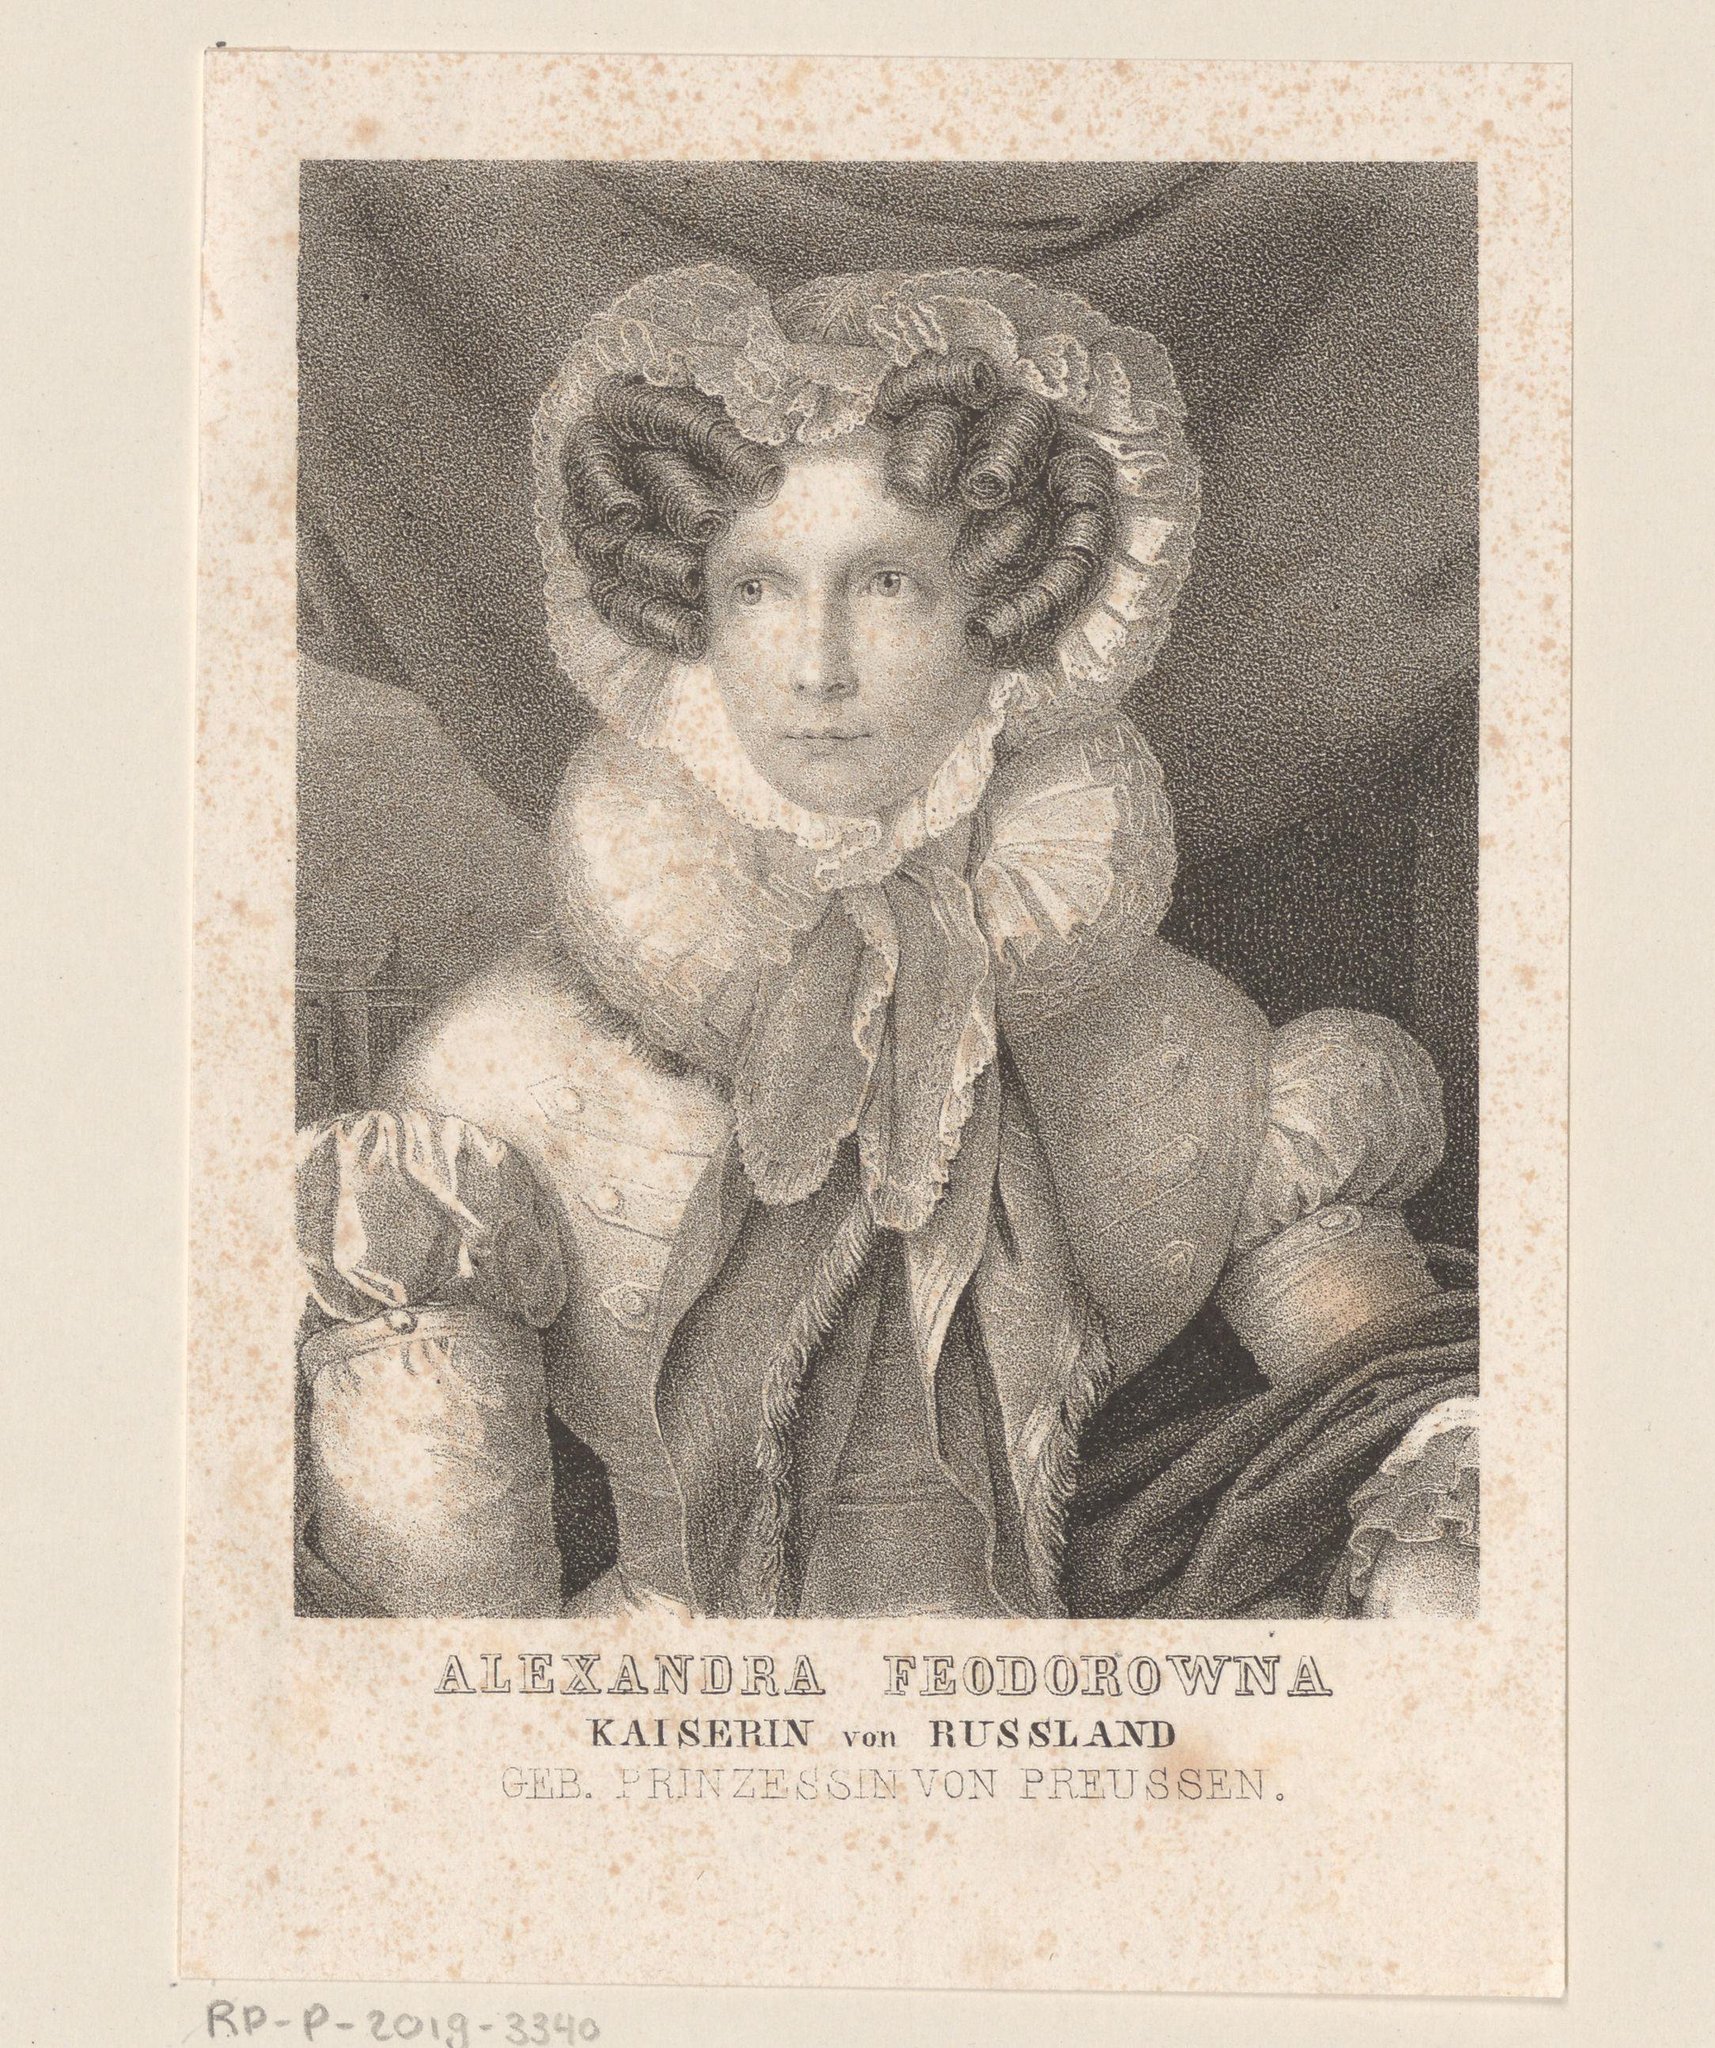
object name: print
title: Portret van Alexandra Fjodorovna, tsarina van Rusland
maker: Anonymous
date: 1820-1825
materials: paper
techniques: lithograph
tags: berlin, historical persons - bb - woman, emperor - bb - female ruler